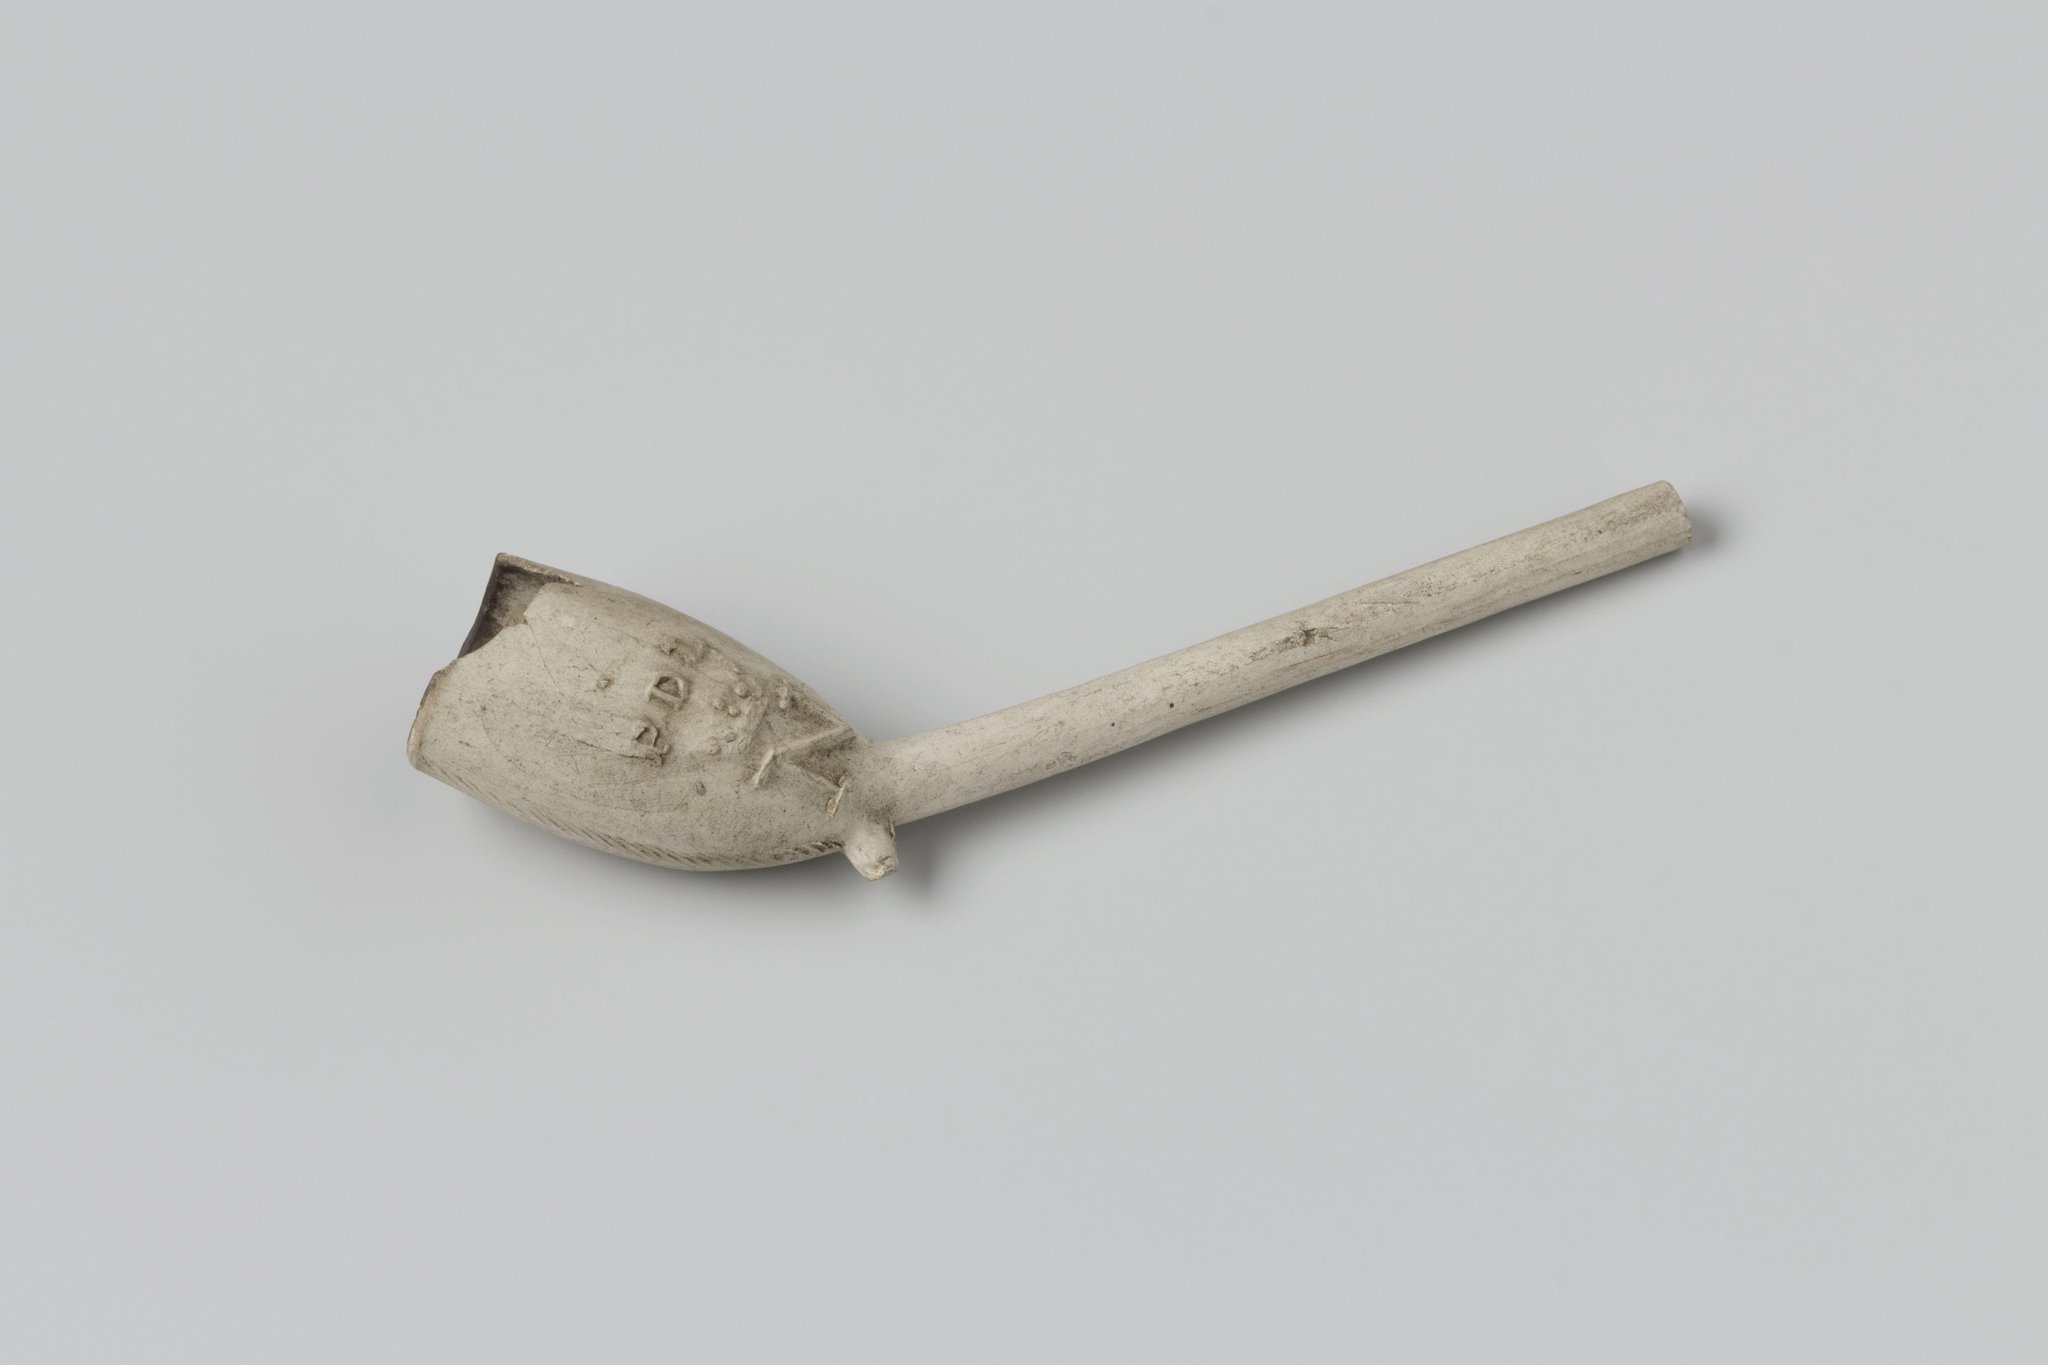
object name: pipe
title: Fragment tabakspijp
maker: pieter de leeuw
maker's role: pijpenfabrikant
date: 1745-1785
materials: clay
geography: schoonhoven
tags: rotterdam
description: Fragment tabakspijp met de letters P D L en gekroonde N. Van de opgravingen op de Hofstede Arentsburg 1827-1831 onder toezicht van Professor Reuvens.